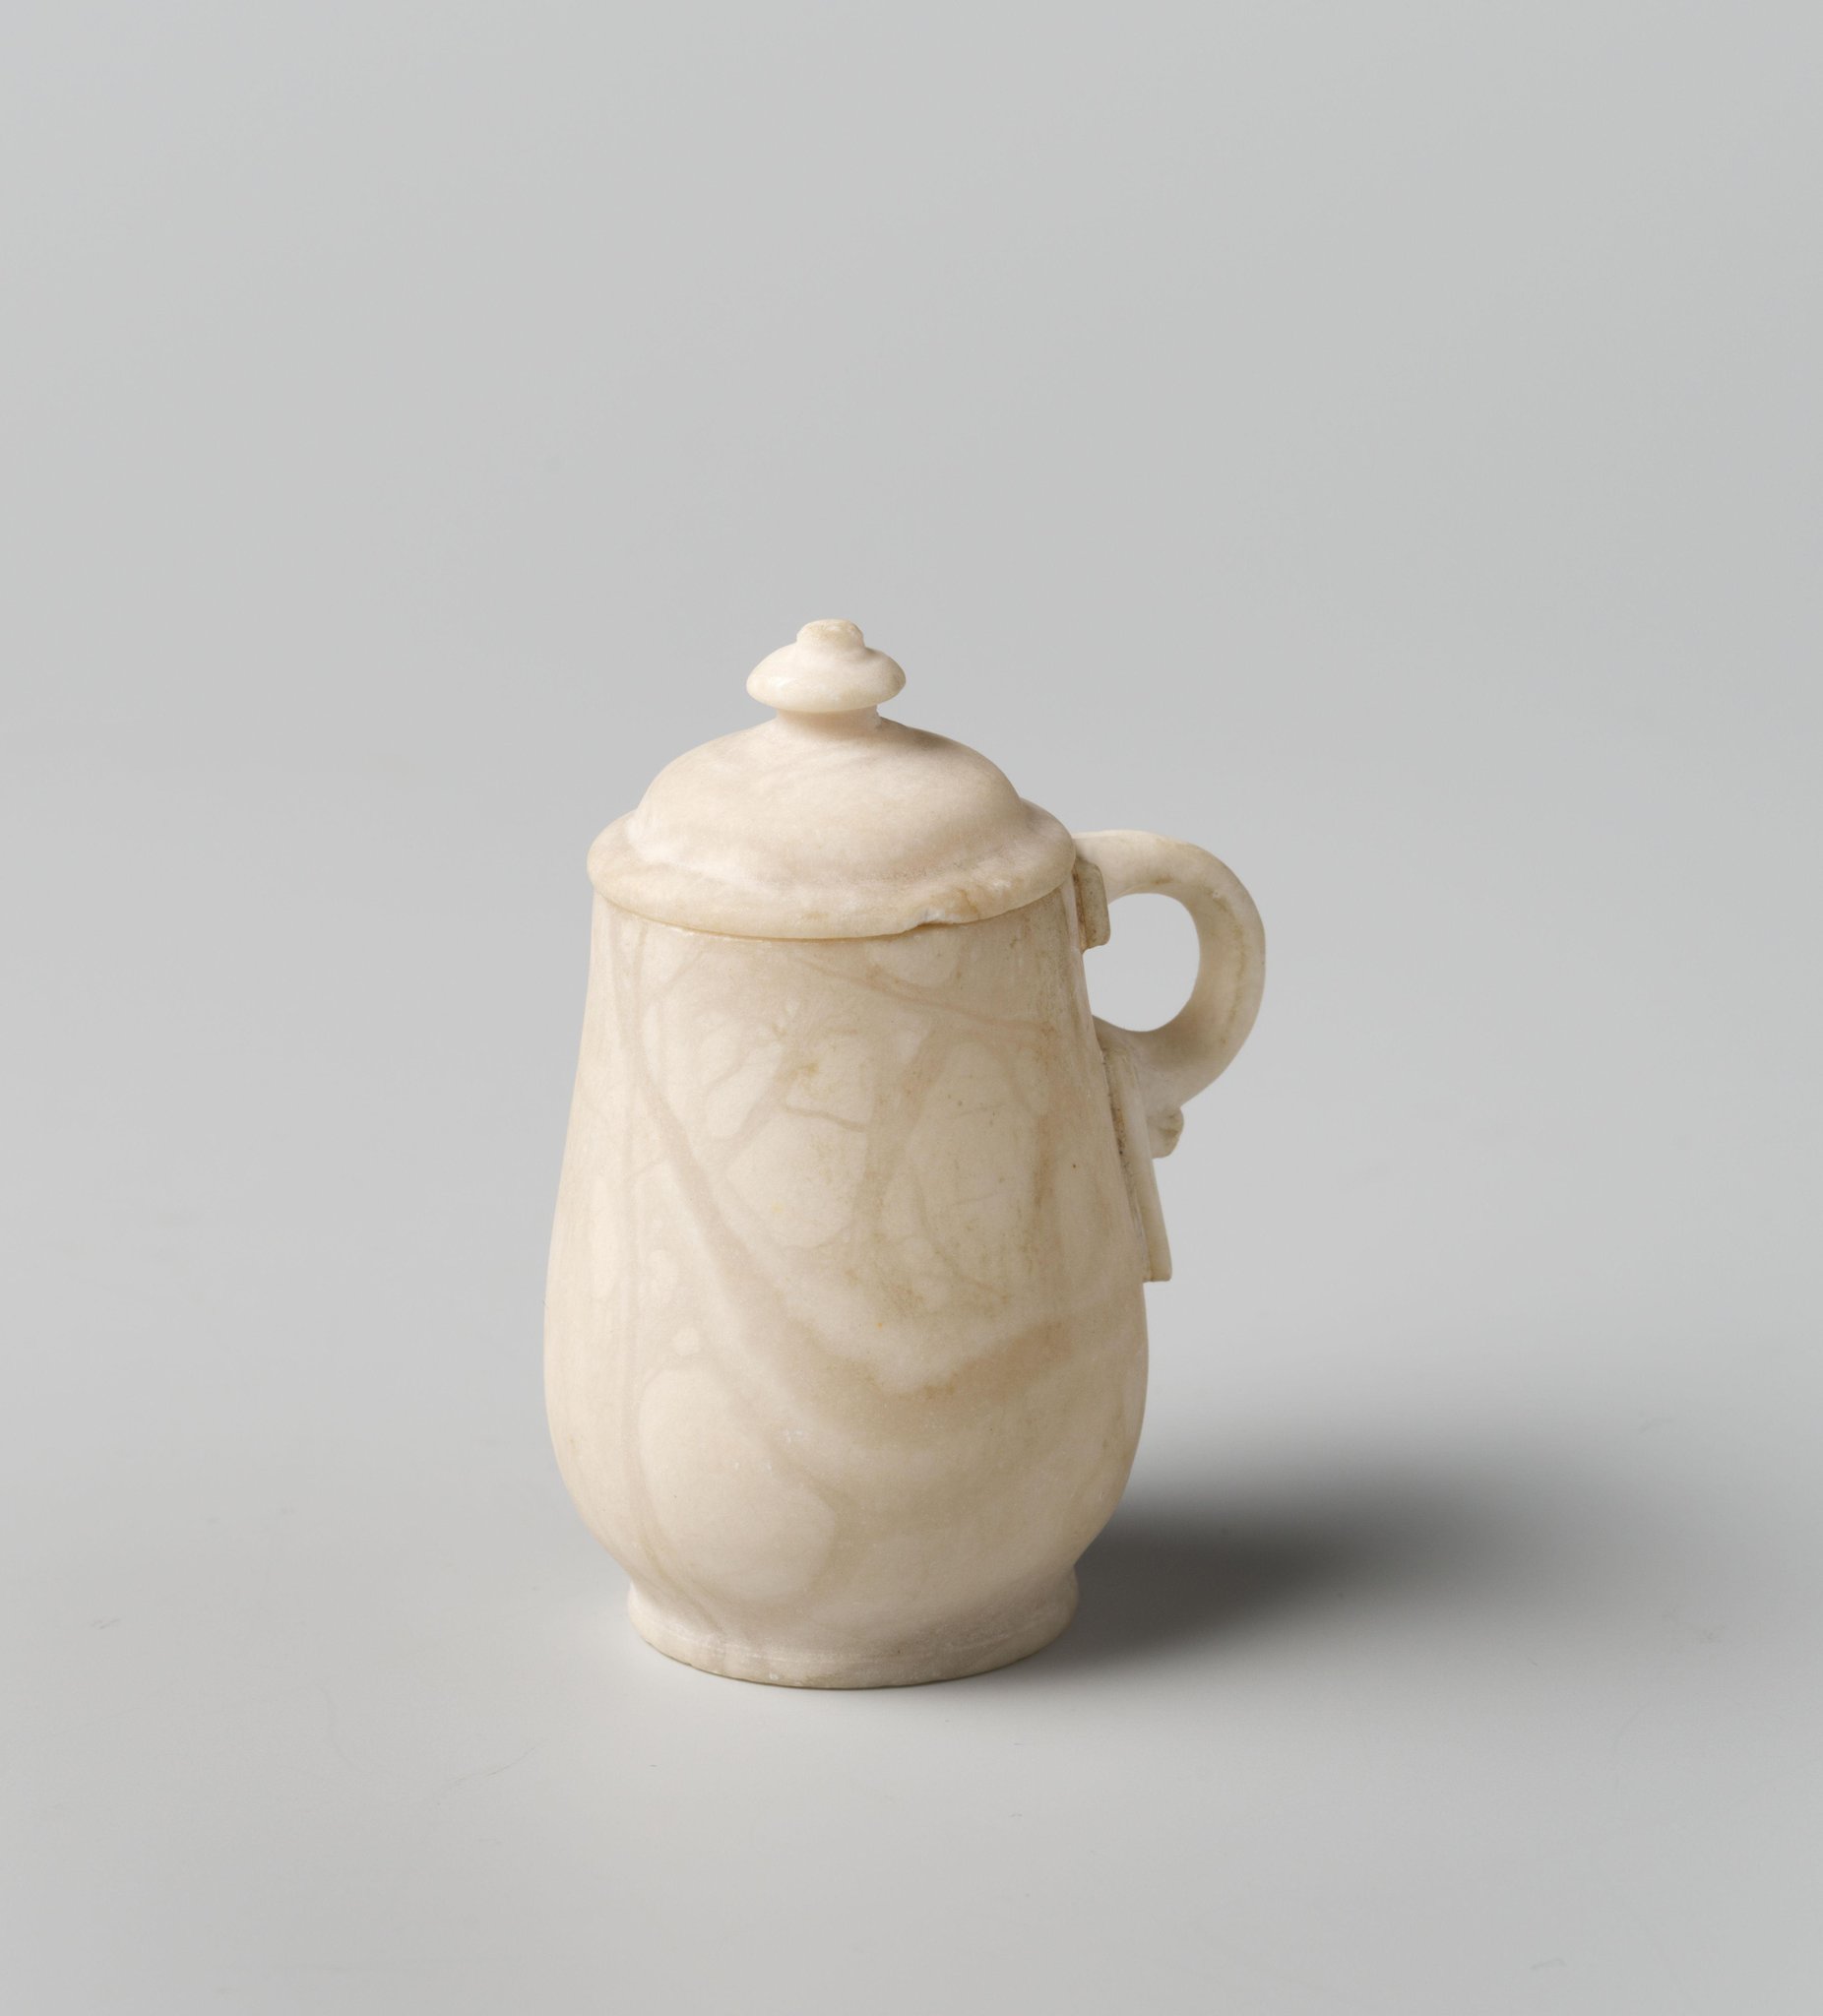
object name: service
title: Kan van albast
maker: Anonymous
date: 1650-1699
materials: alabaster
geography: netherlands